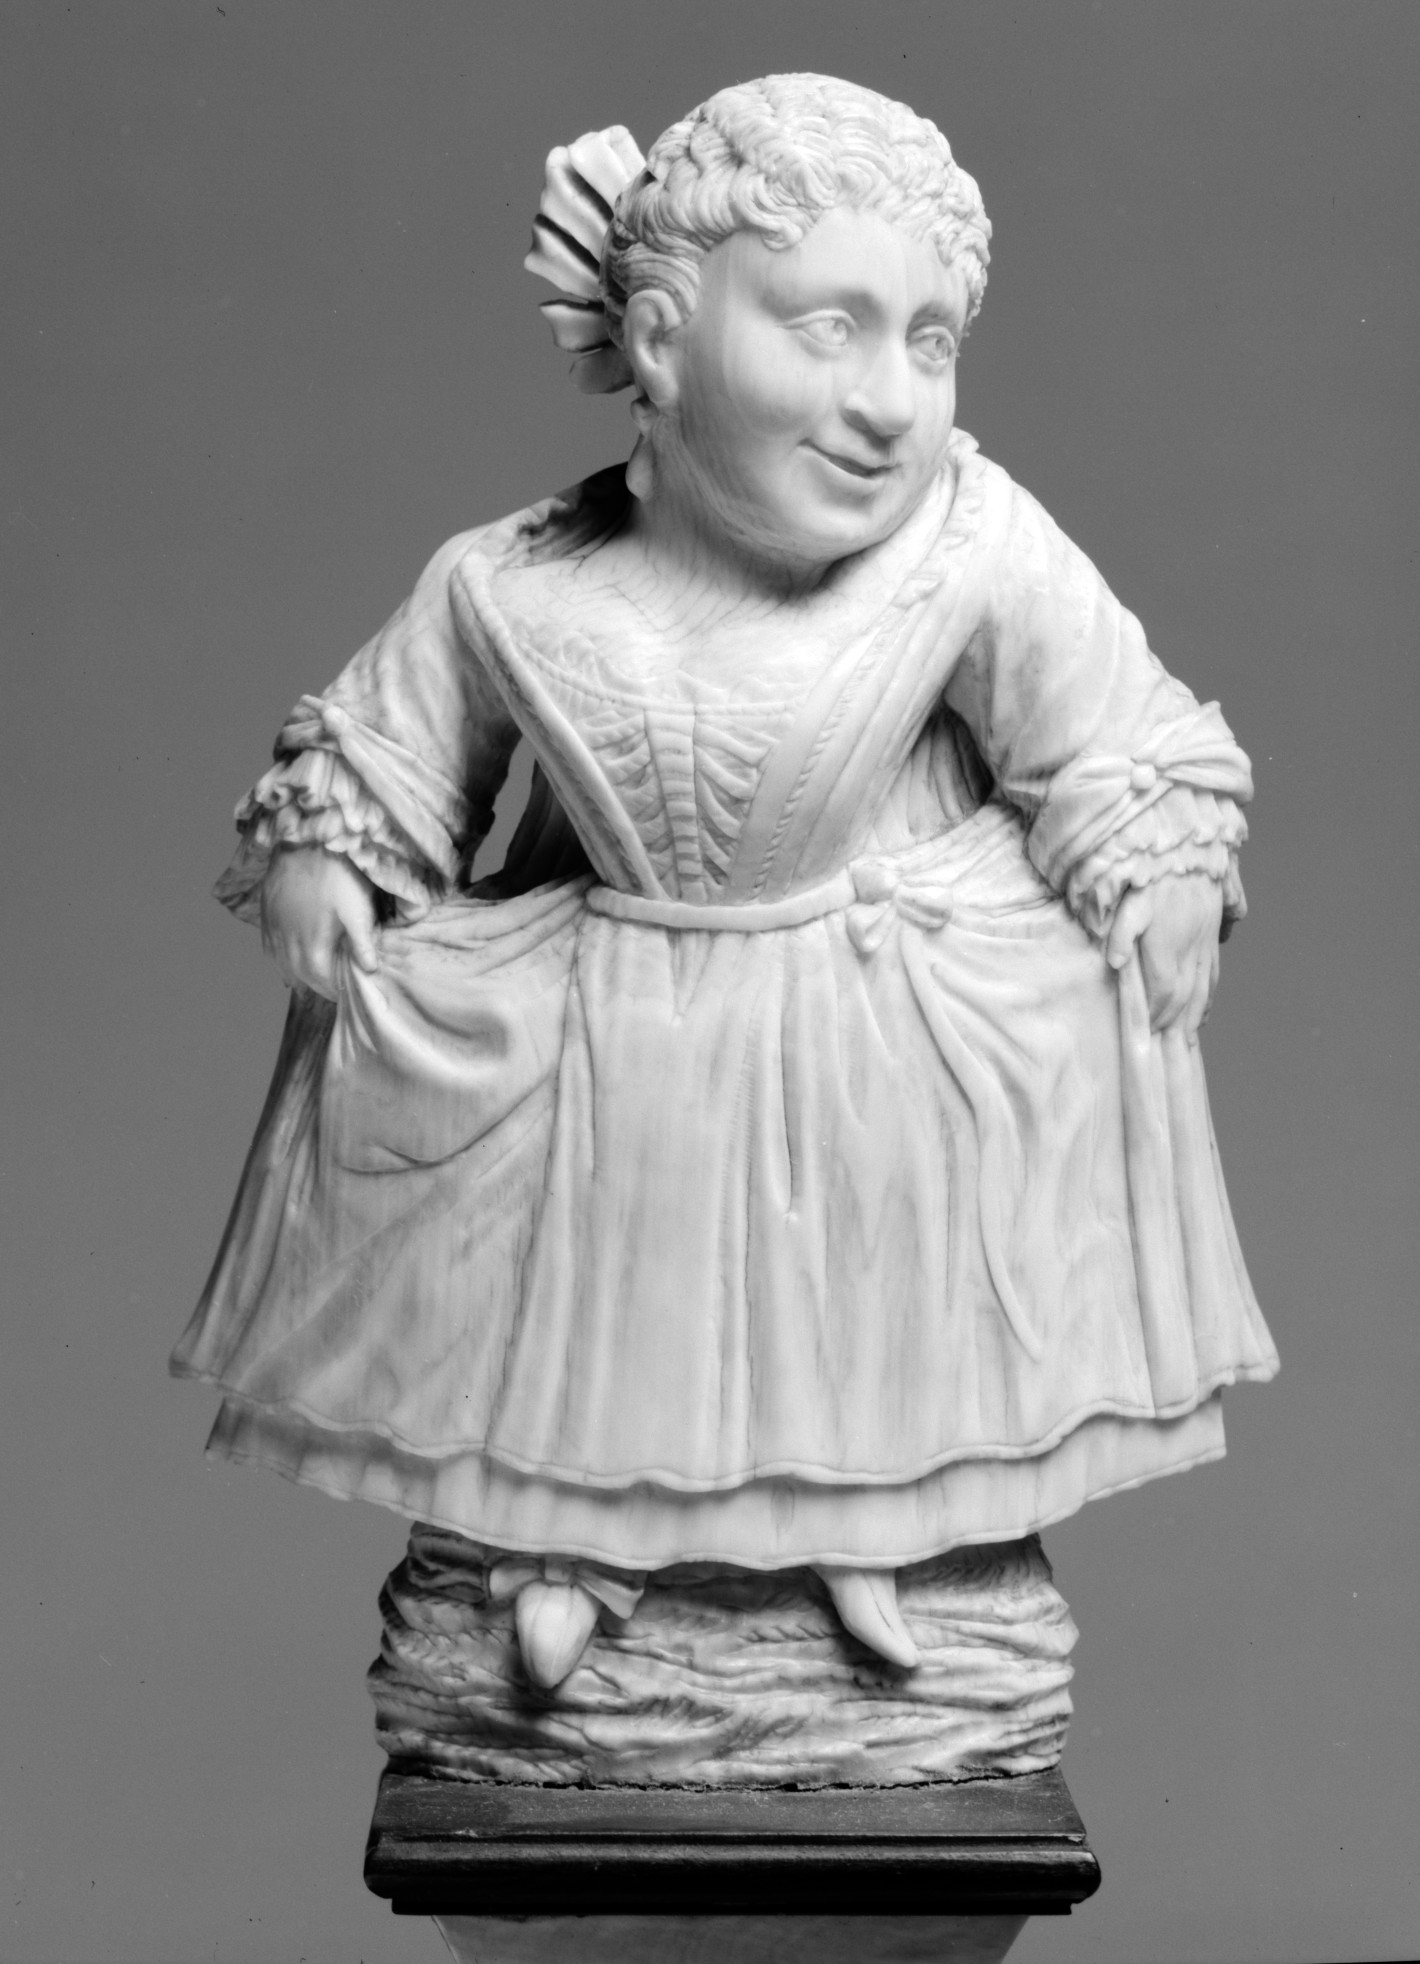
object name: relief figure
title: Female Dancing Dwarf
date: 1734-1766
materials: ivory, wood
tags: women,dancing